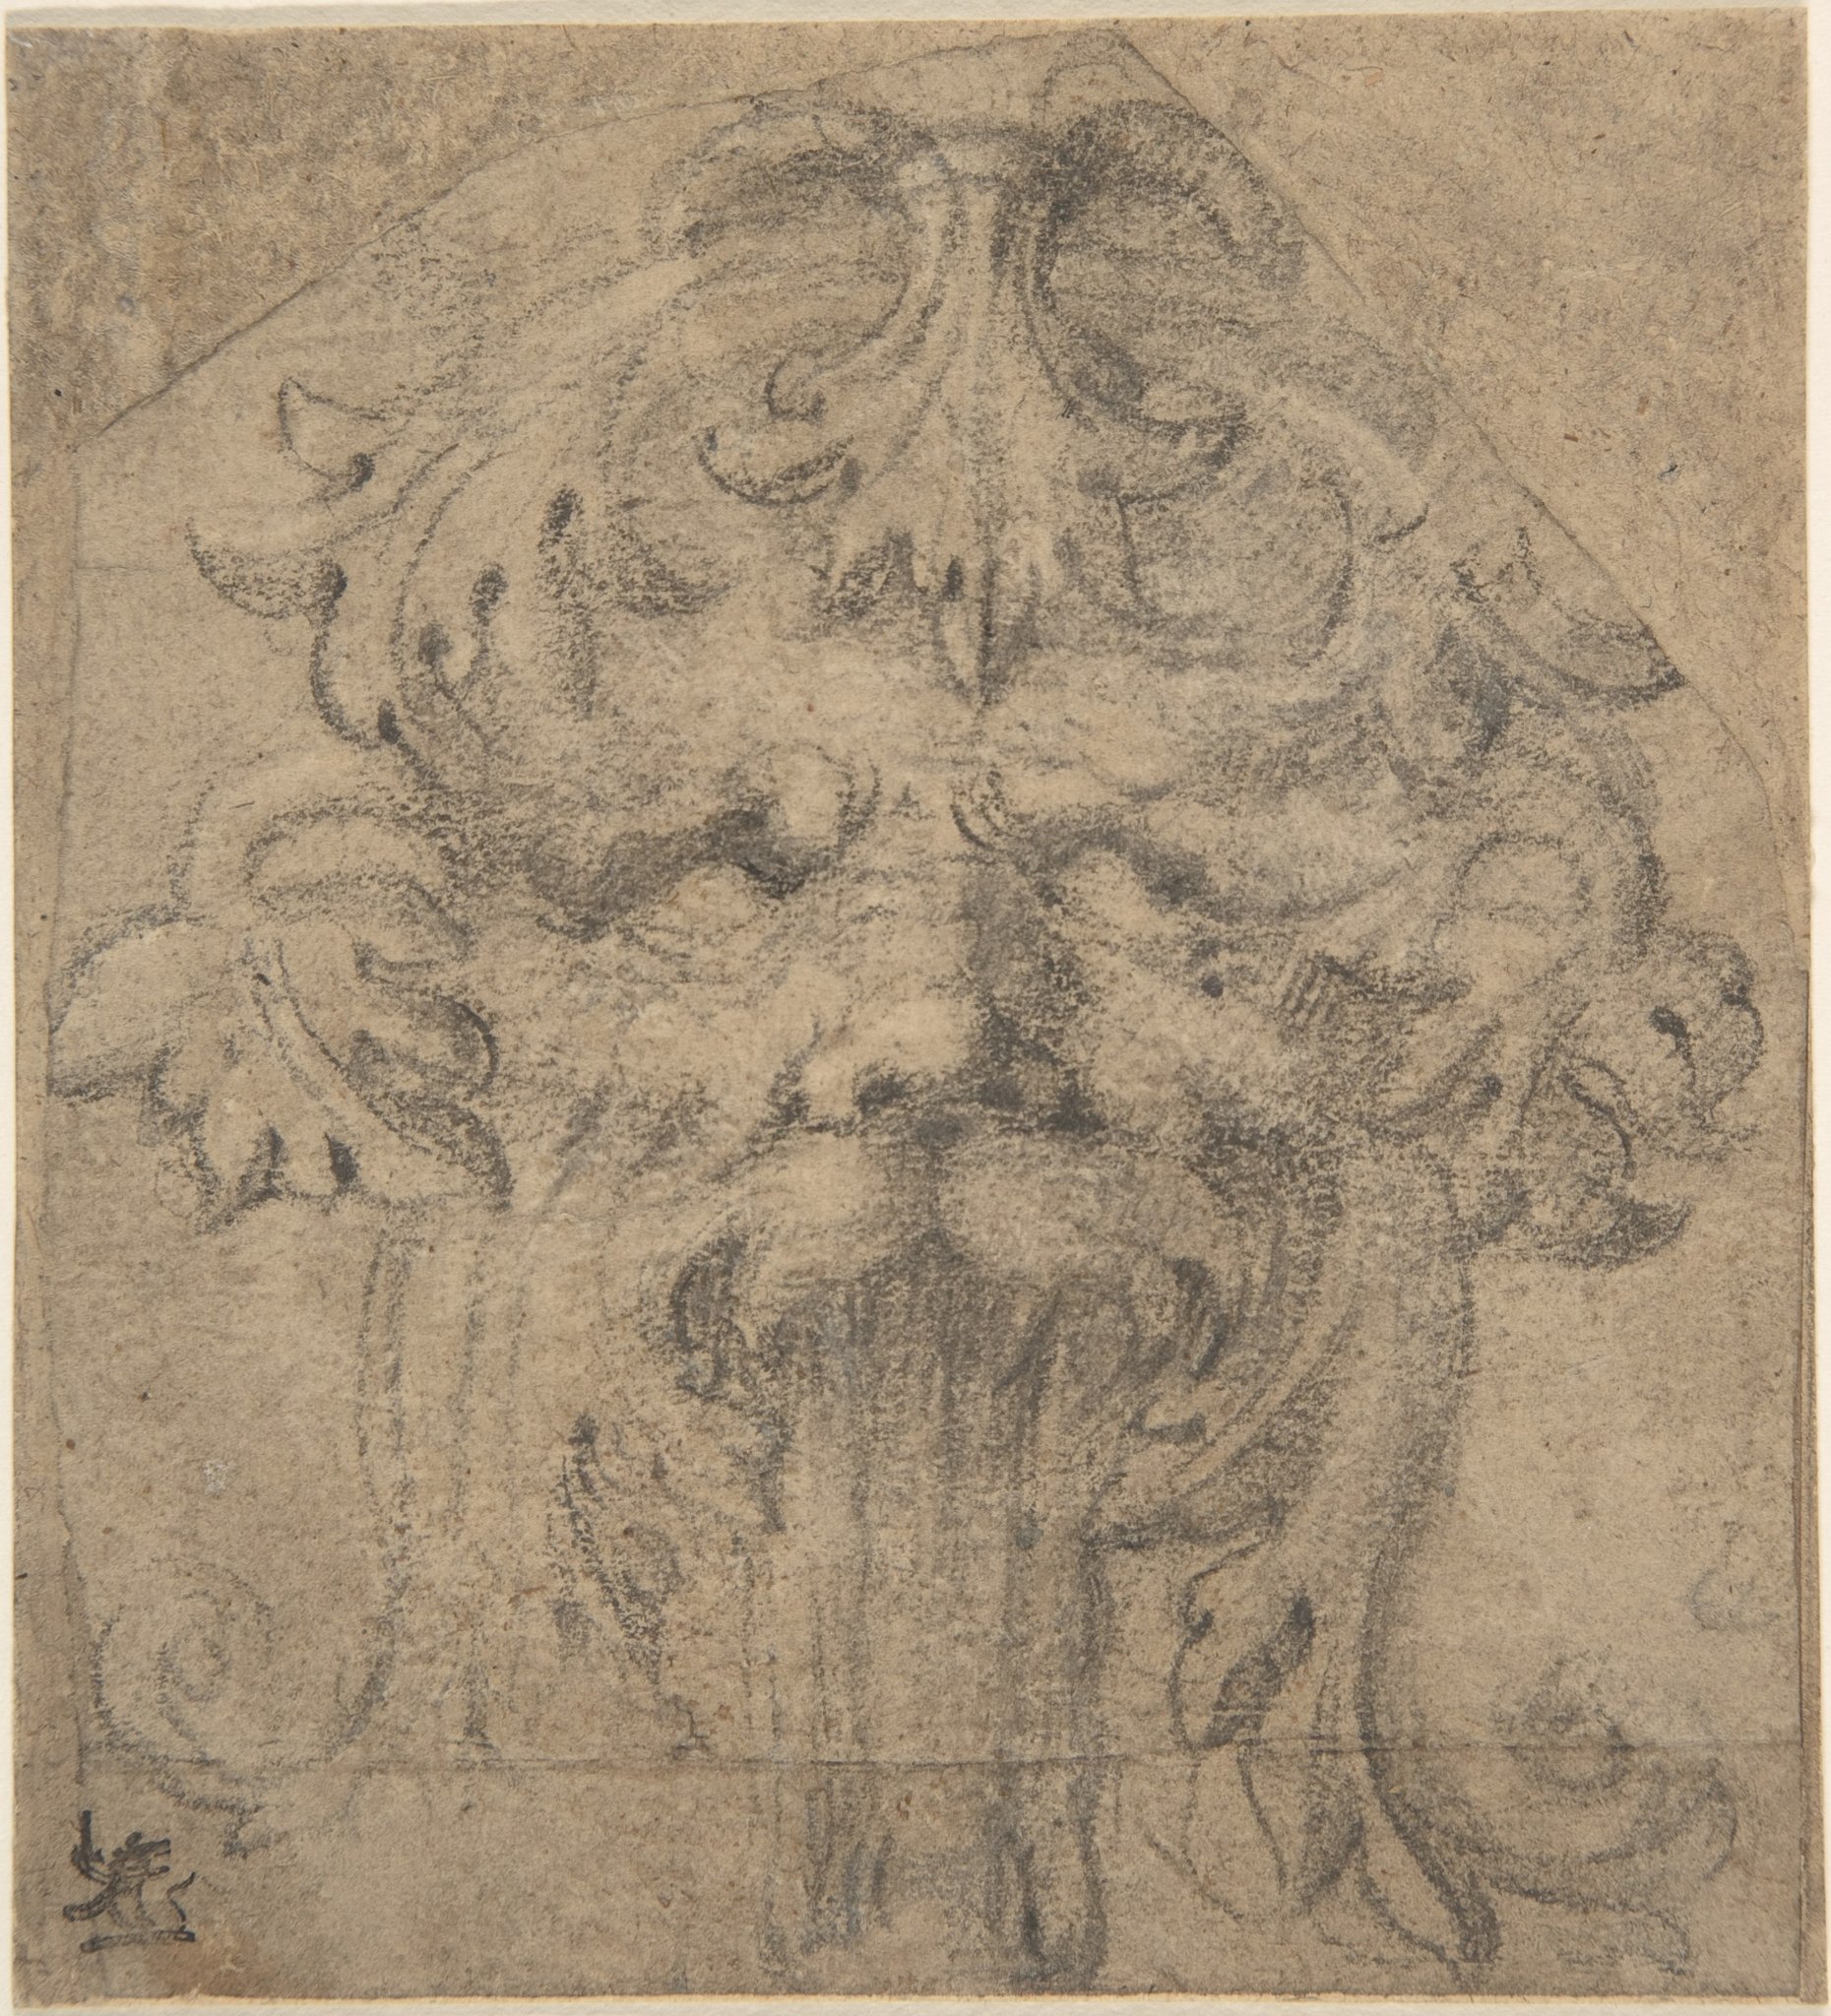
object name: drawing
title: Foliate Grotesque Head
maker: anonymous, italian, 16th to 17th century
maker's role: artist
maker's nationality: italian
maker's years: 1500-1700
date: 1501-1700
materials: chalk, graphite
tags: grotesques,heads